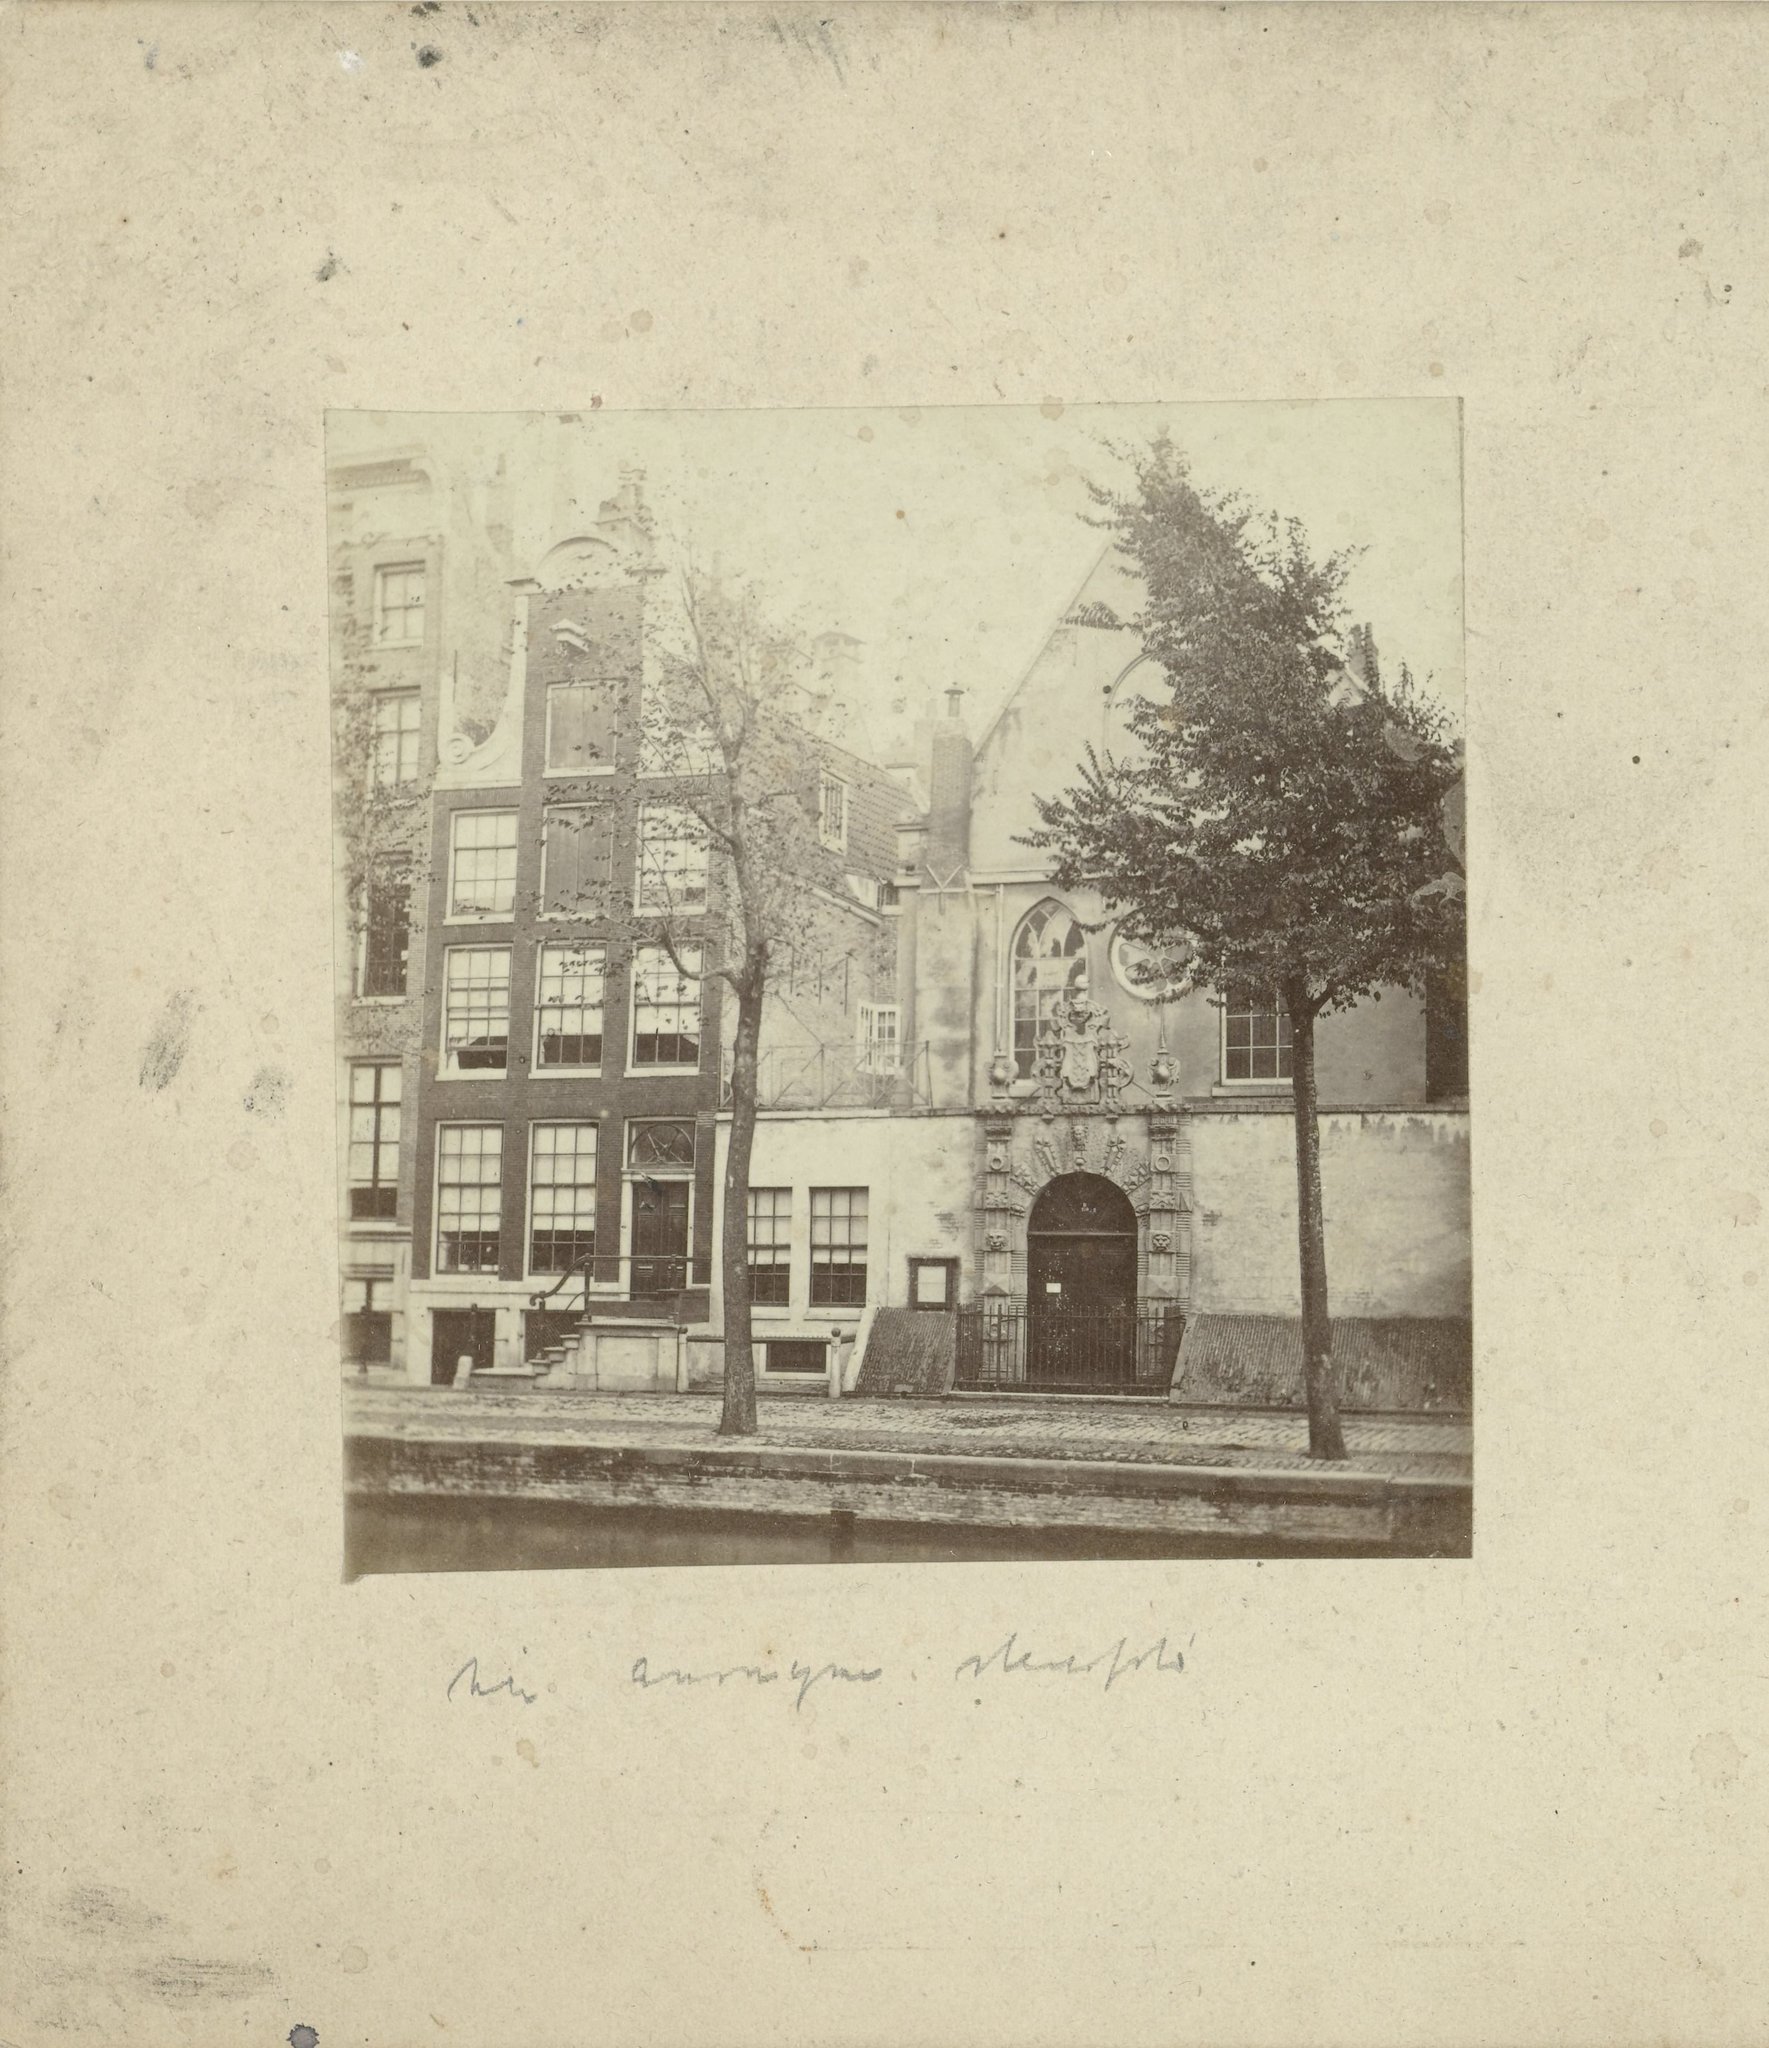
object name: photograph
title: De Illustre School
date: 1860-1875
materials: cardboard, paper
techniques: albumen print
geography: amsterdam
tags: university